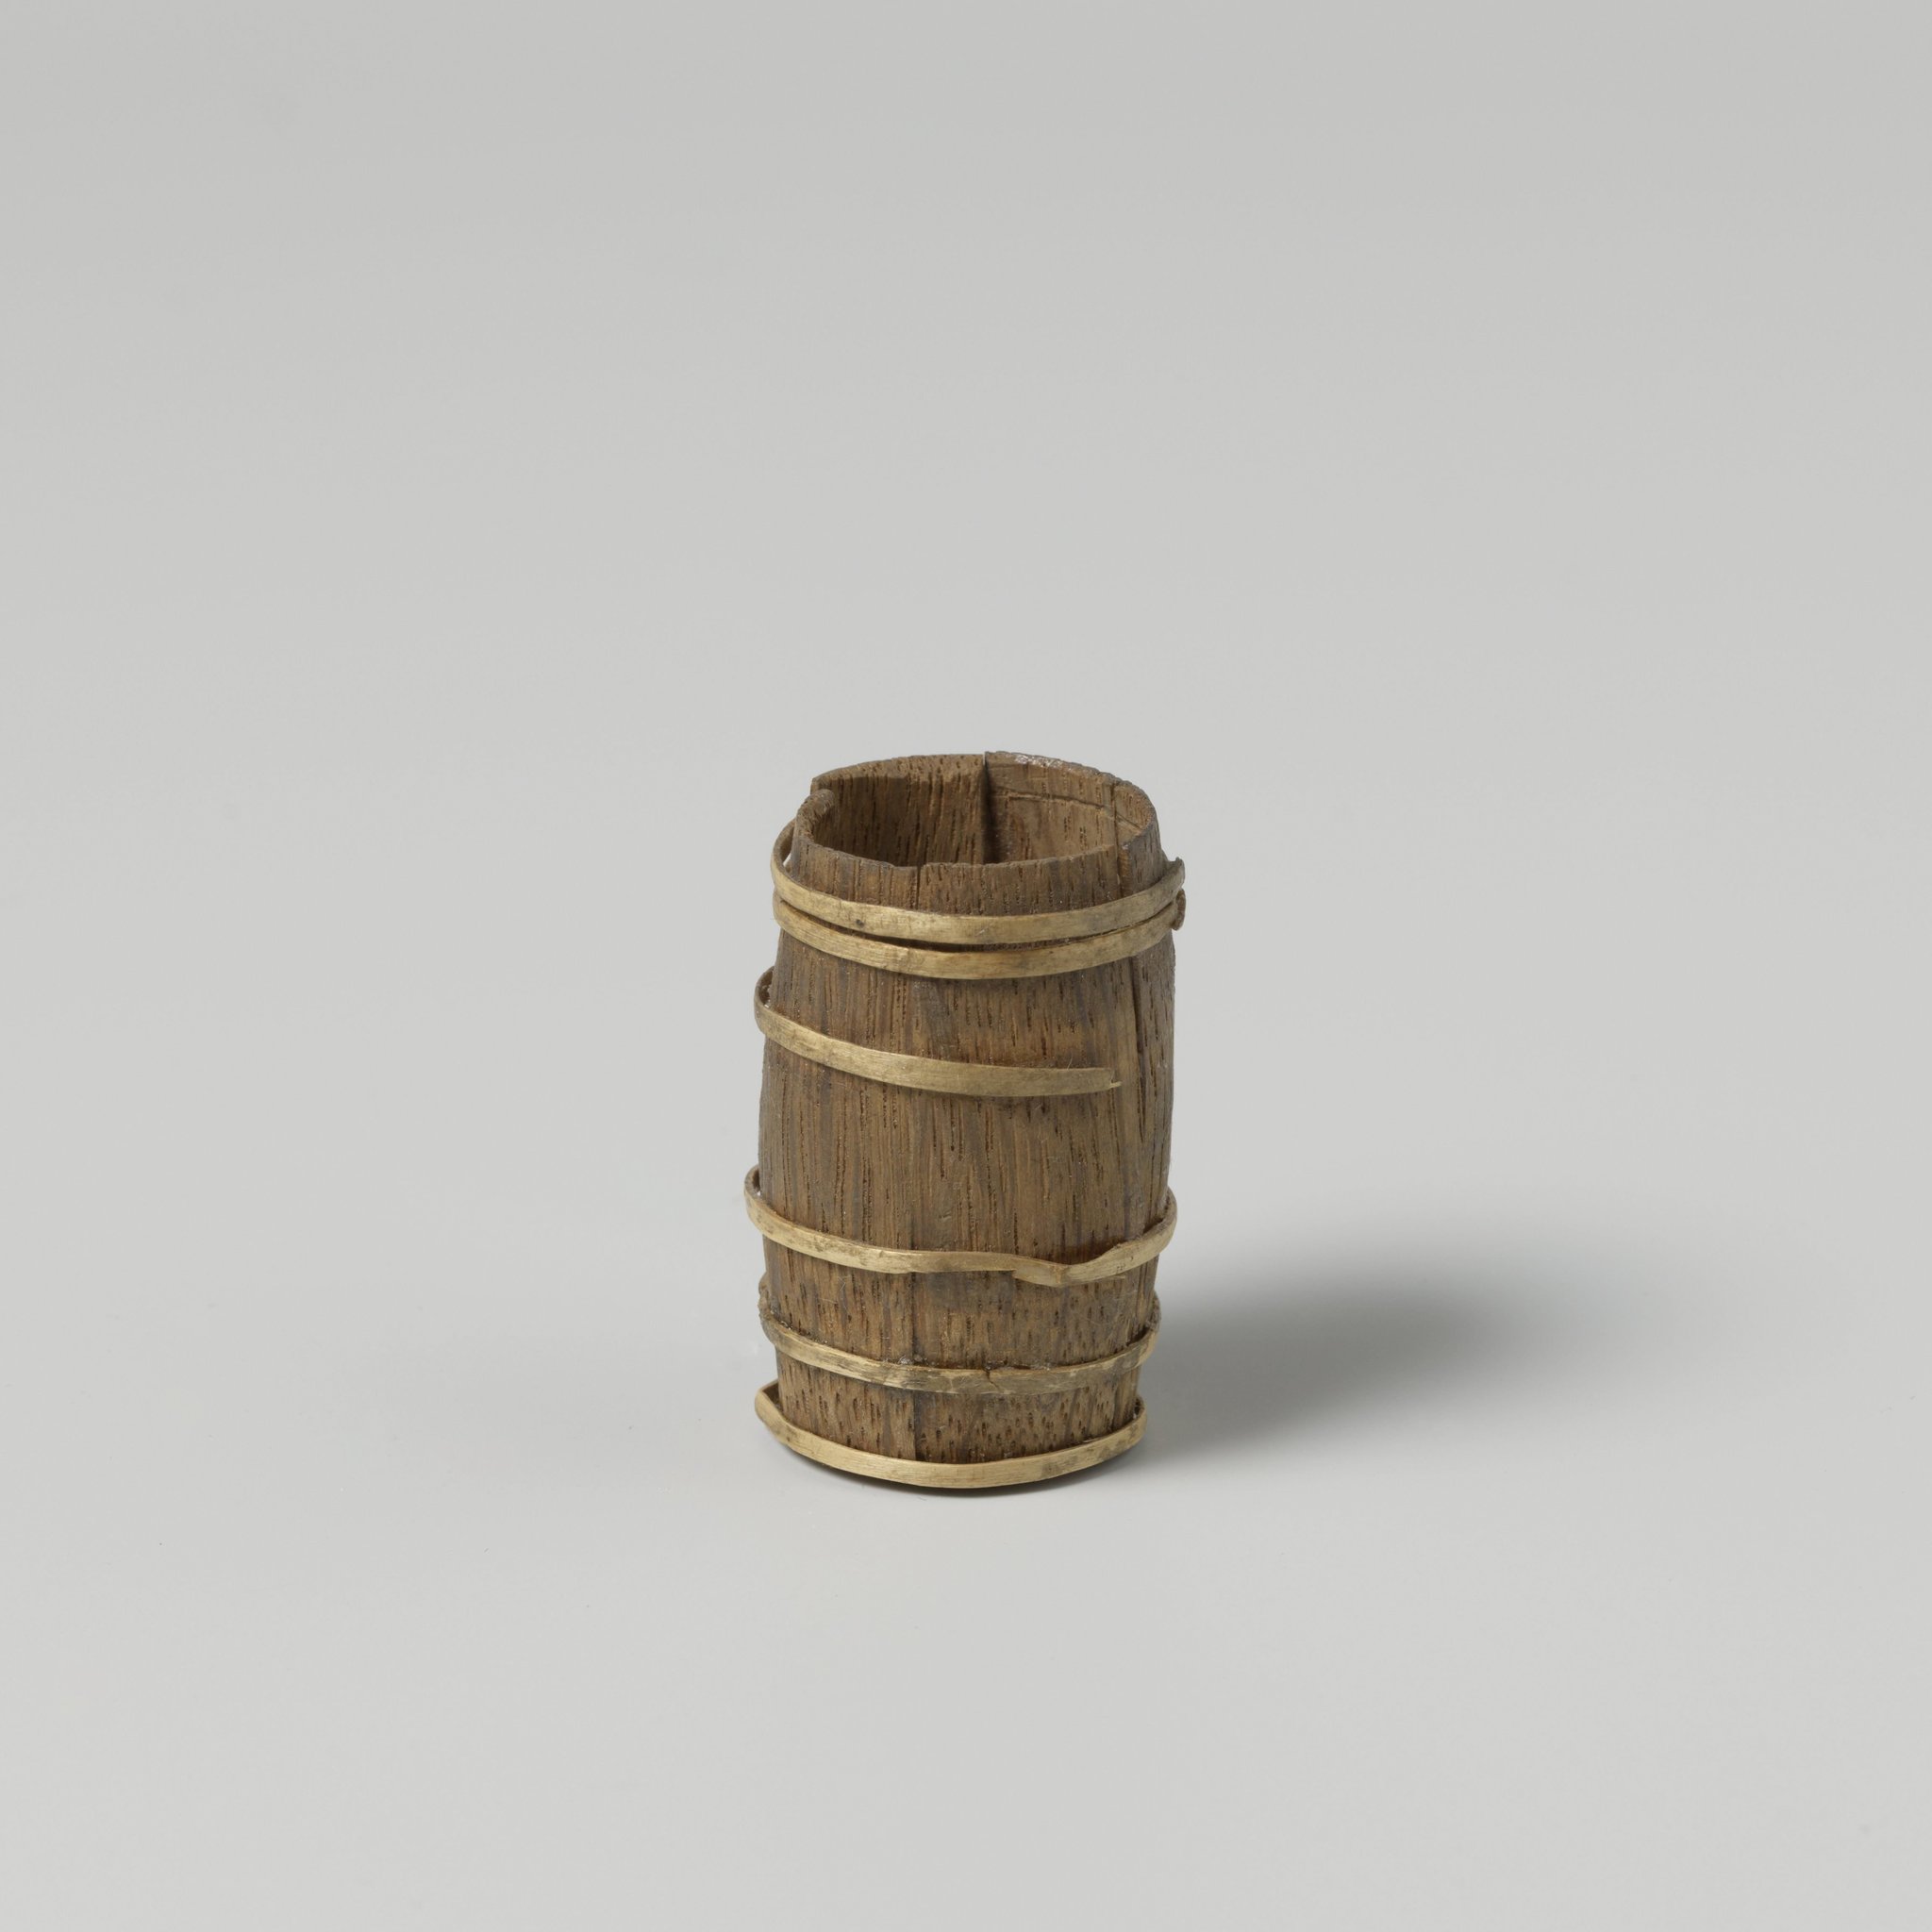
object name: tun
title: Ton, vervaardigd uit duigen omwonden met negen en zes hoepels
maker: Anonymous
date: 1700-1799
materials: wood, plant material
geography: amsterdam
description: Een ton gemaakt van losse eikenhouten duigen, omwonden met negen en zes hoepels van ongescholde wilgenteen.